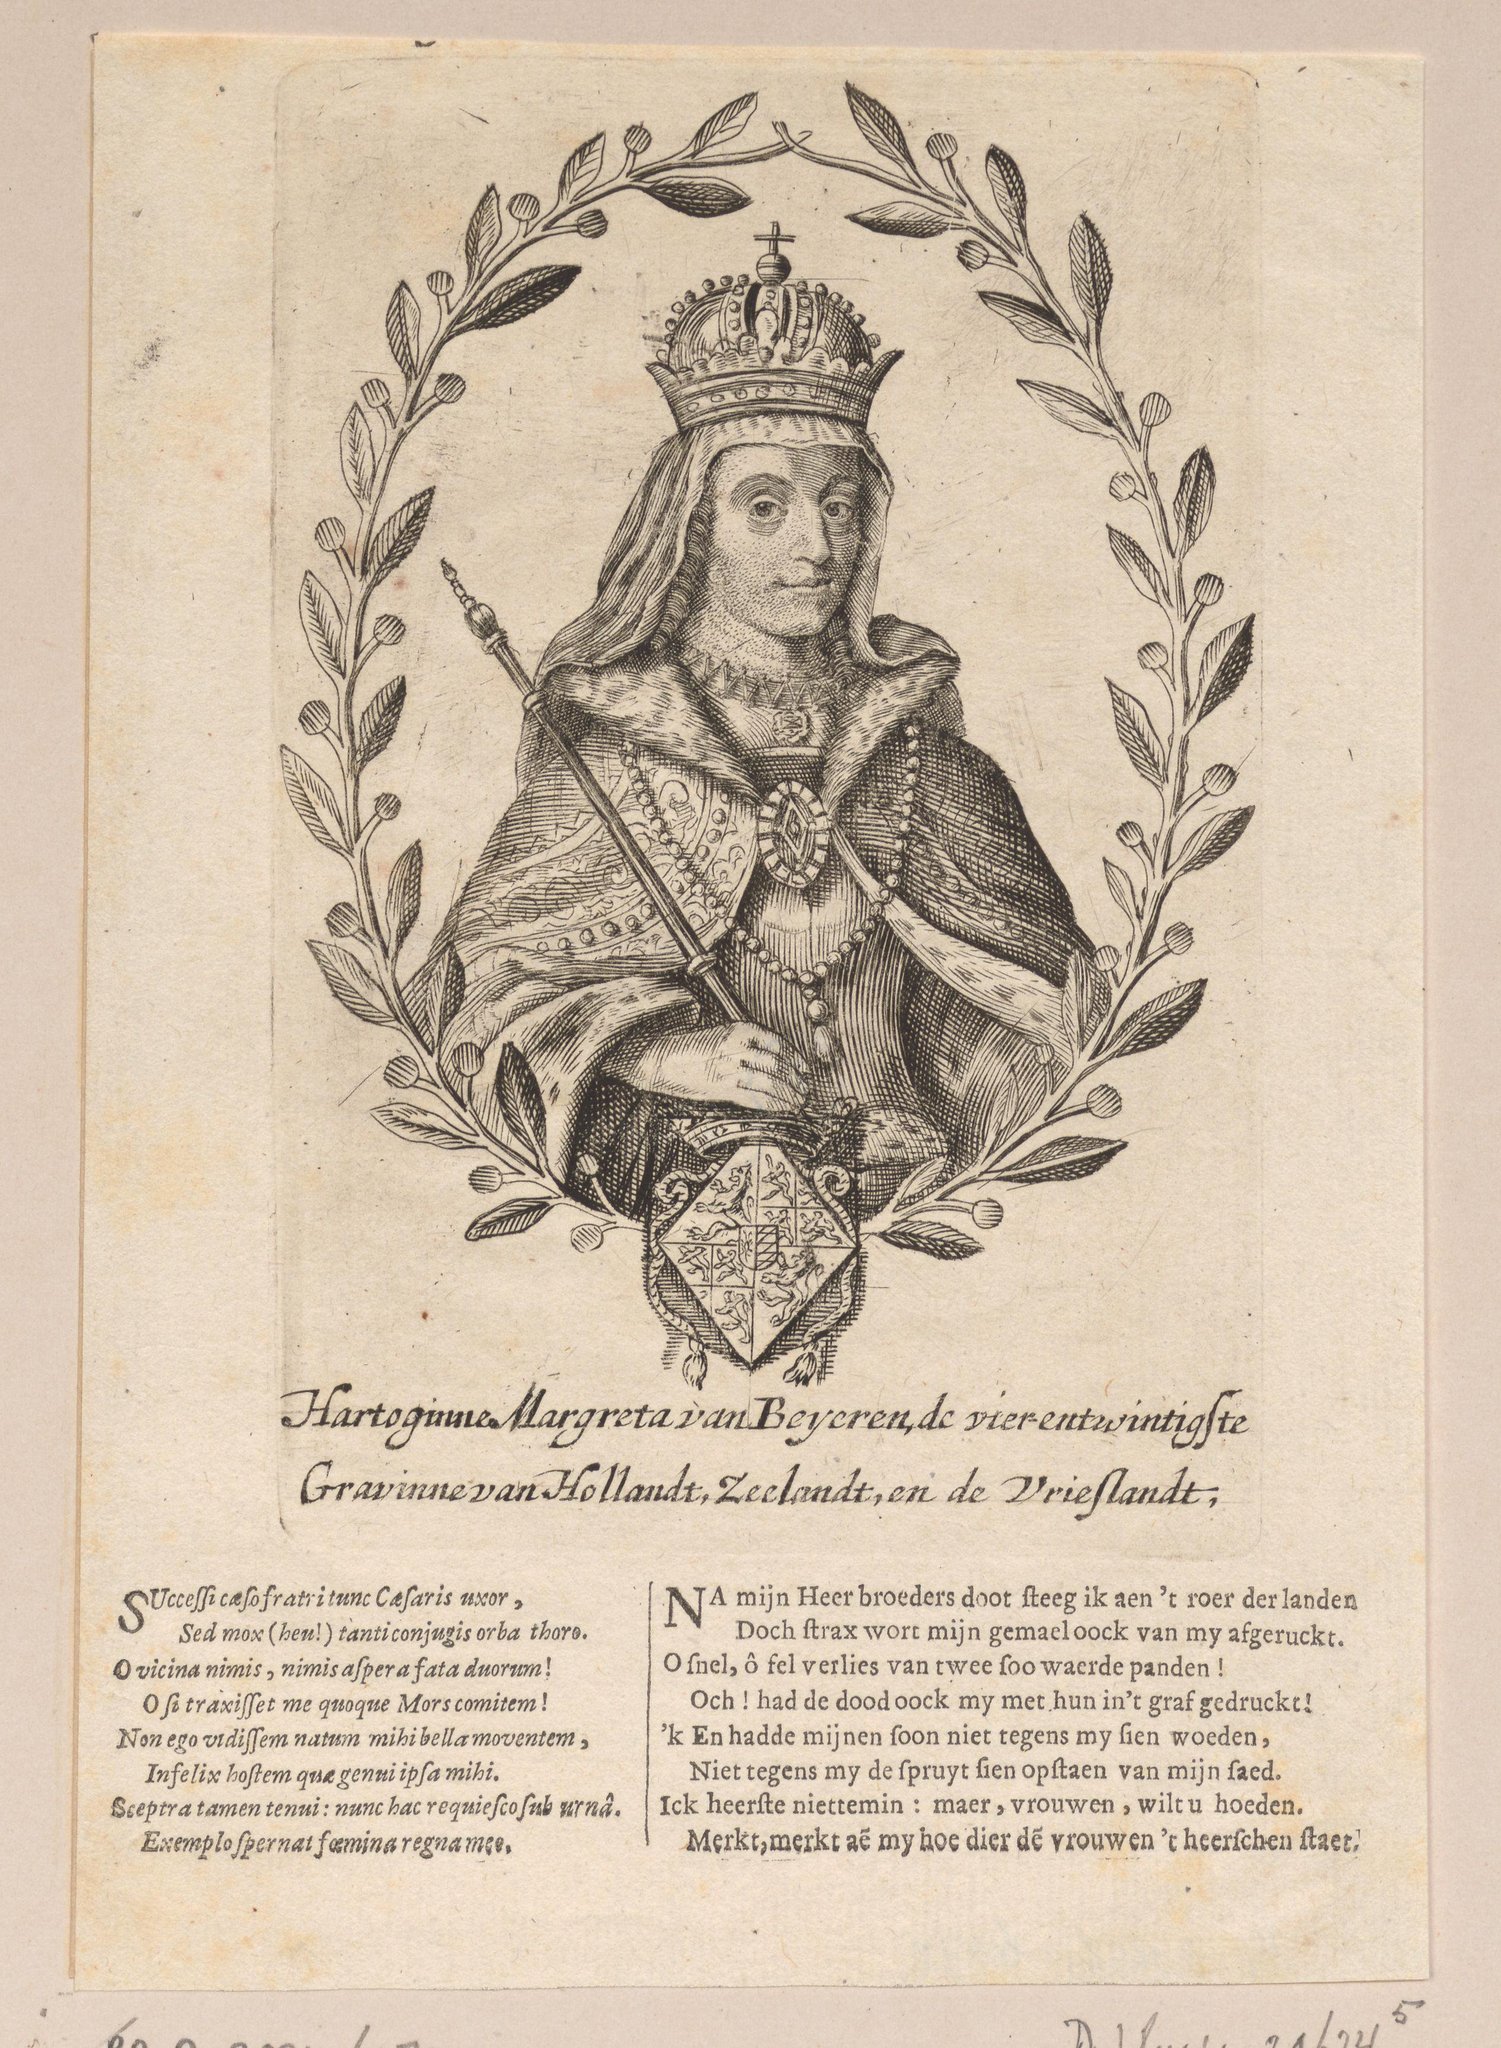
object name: print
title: Portret van Margaretha II van Henegouwen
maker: Anonymous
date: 1678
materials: paper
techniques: engraving, letterpress printing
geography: northern netherlands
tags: sceptre, staff (symbol of sovereignty) - bb - female ruler, historical persons - bb - woman, crown (symbol of sovereignty) - bb - female ruler, armorial bearing, heraldry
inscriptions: collector's mark: Lugt 964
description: Prent waarschijnlijk uit: Scriverius, Petrus. Hollandsche, Zeelandsche ende Vriesche Chronyk (...). Den Haag: Johannes Tongerloo en Levijn van Dijck I, 1678, p. 300. Eerdere staat gebruikt in publicaties uit 1645 en 1648.